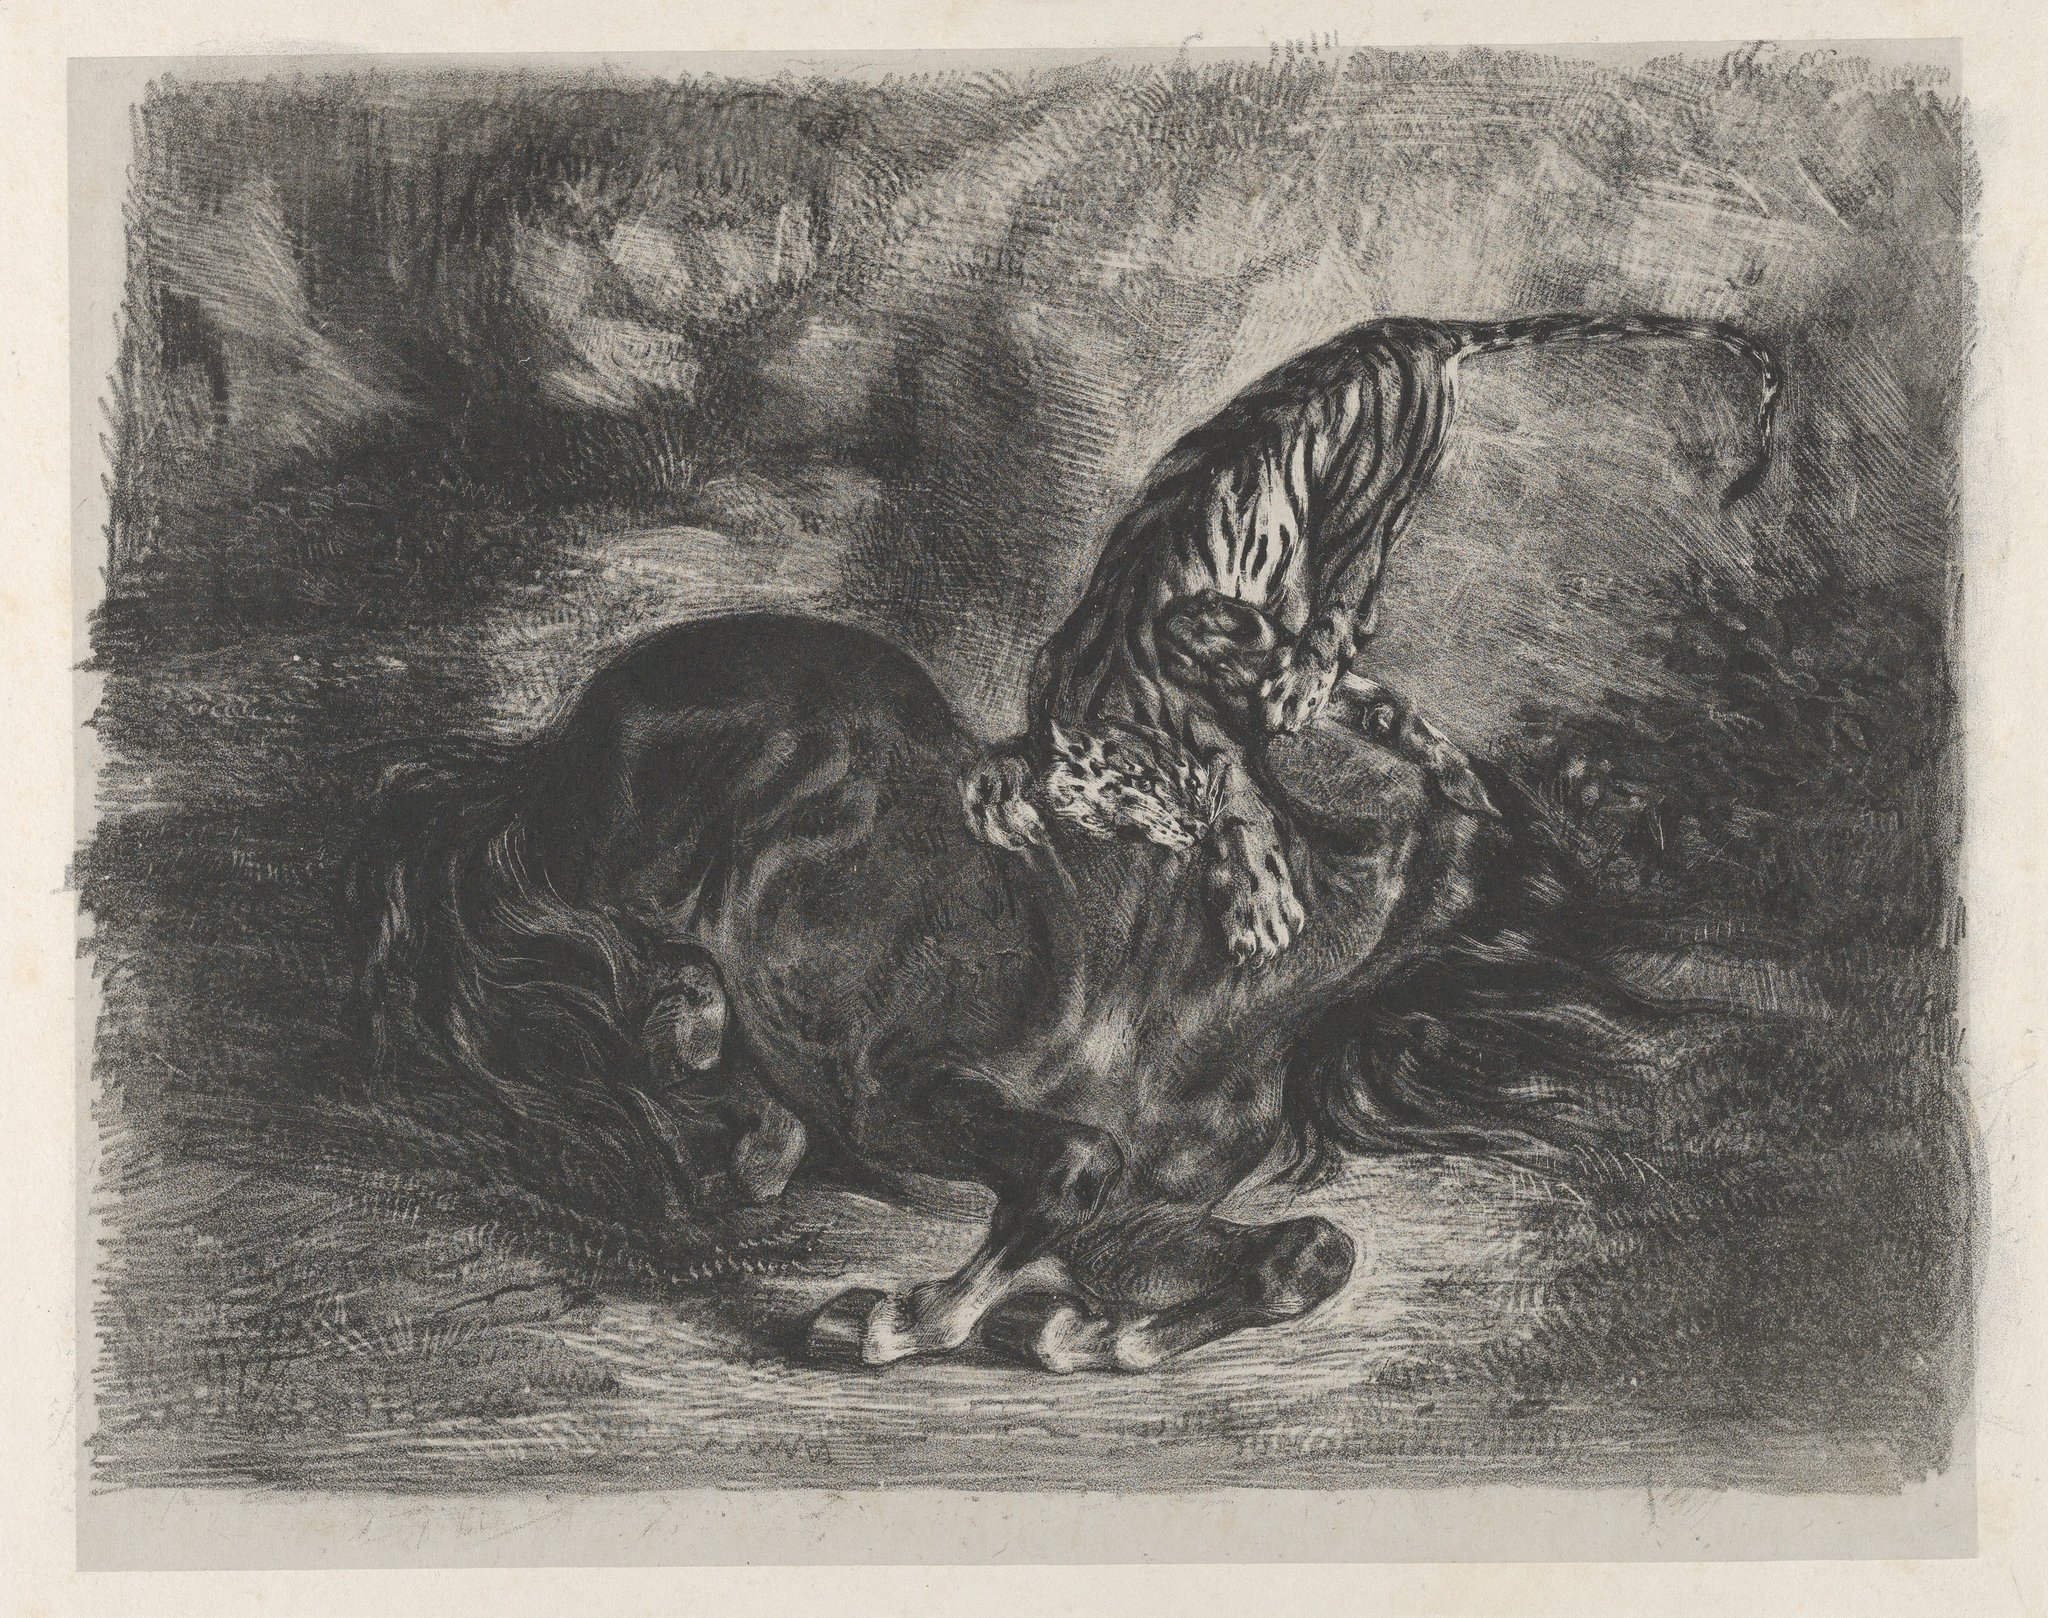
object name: print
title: Wild Horse Felled by a Tiger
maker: eugène delacroix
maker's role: artist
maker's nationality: french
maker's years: 1798-1863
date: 1828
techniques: printmaking, lithograph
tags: horses,tigers